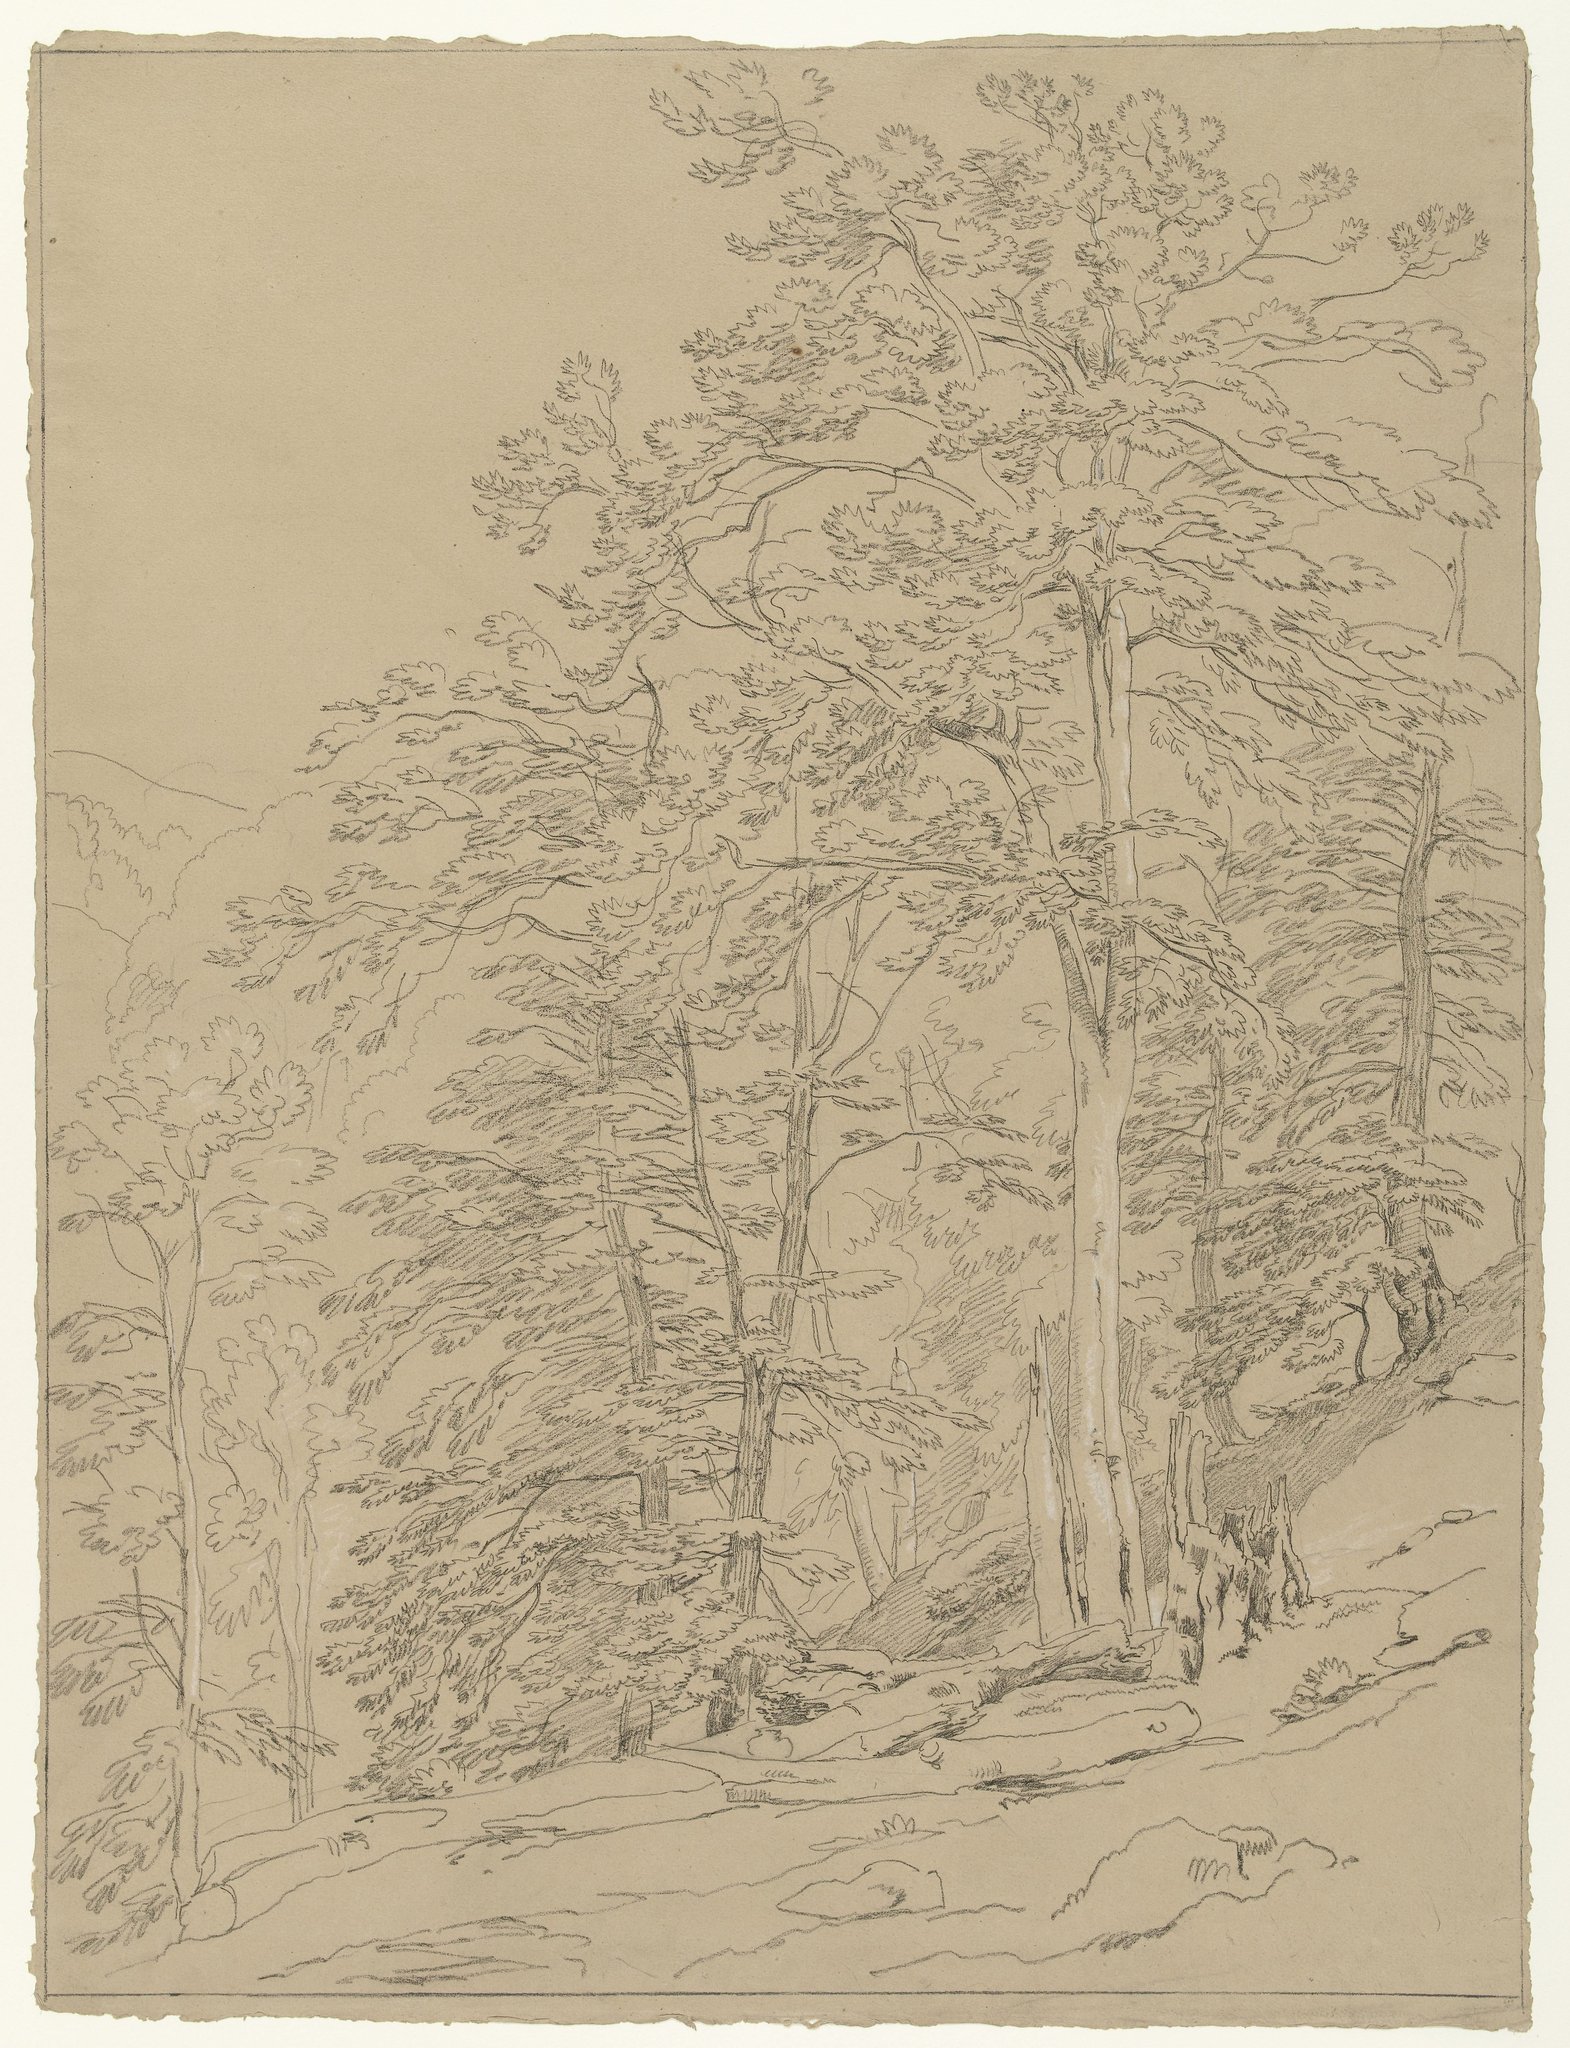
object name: drawing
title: Berglandschap met hoog opgaand geboomte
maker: hendrik voogd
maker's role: draughtsman, painter, print maker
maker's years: 1768-1839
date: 1788-1839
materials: chalk, paper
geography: rome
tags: forest, wood, mountains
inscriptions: inscription: ‘Sulla montagna a / Roco anticha H Voogd // de groote boom heel wit / de twee di achter hem staan in schaaduw’